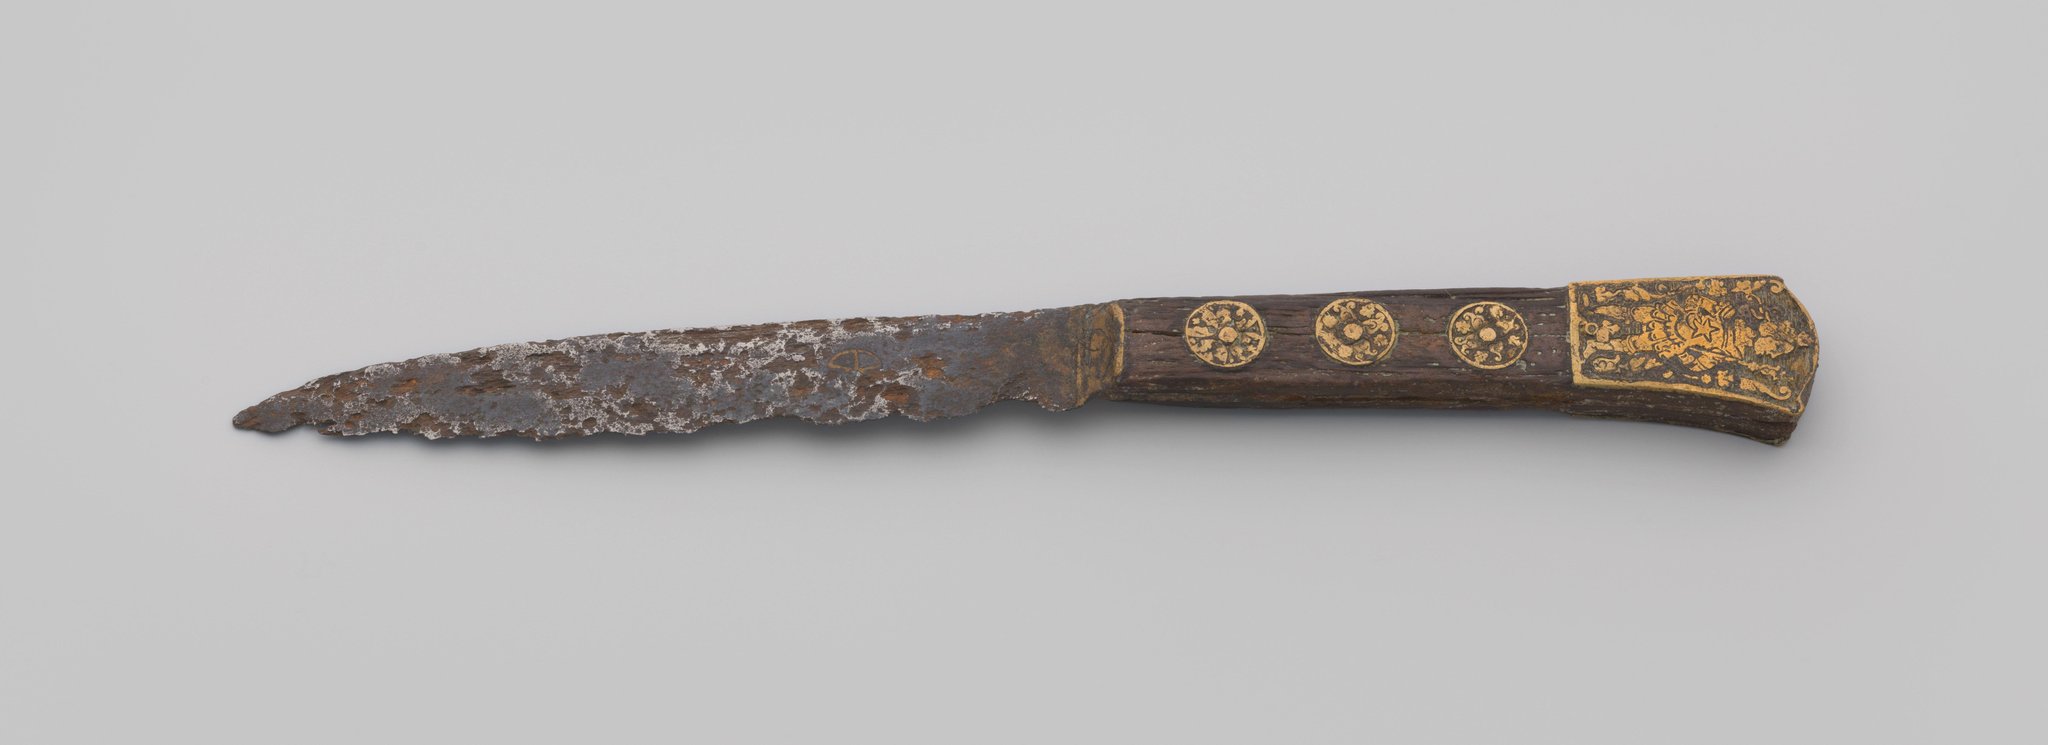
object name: knife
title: Mes met houten heft versierd met gegraveerd koper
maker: Anonymous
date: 1500-1600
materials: copper, iron, wood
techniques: metalworking, engraving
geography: southern netherlands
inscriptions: quality mark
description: Mes met lemmet van ijzer. Het houten heft is versierd met aan weerszijden drie ronde koperen plaatjes met een rozet. De koperen bekroning toont aan de ene zijde een geharnaste man met in de ene hand een stervormige scepter en in de andere een staf. De andere zijde toont een bijna geheel naakte vrouw met bloemen.